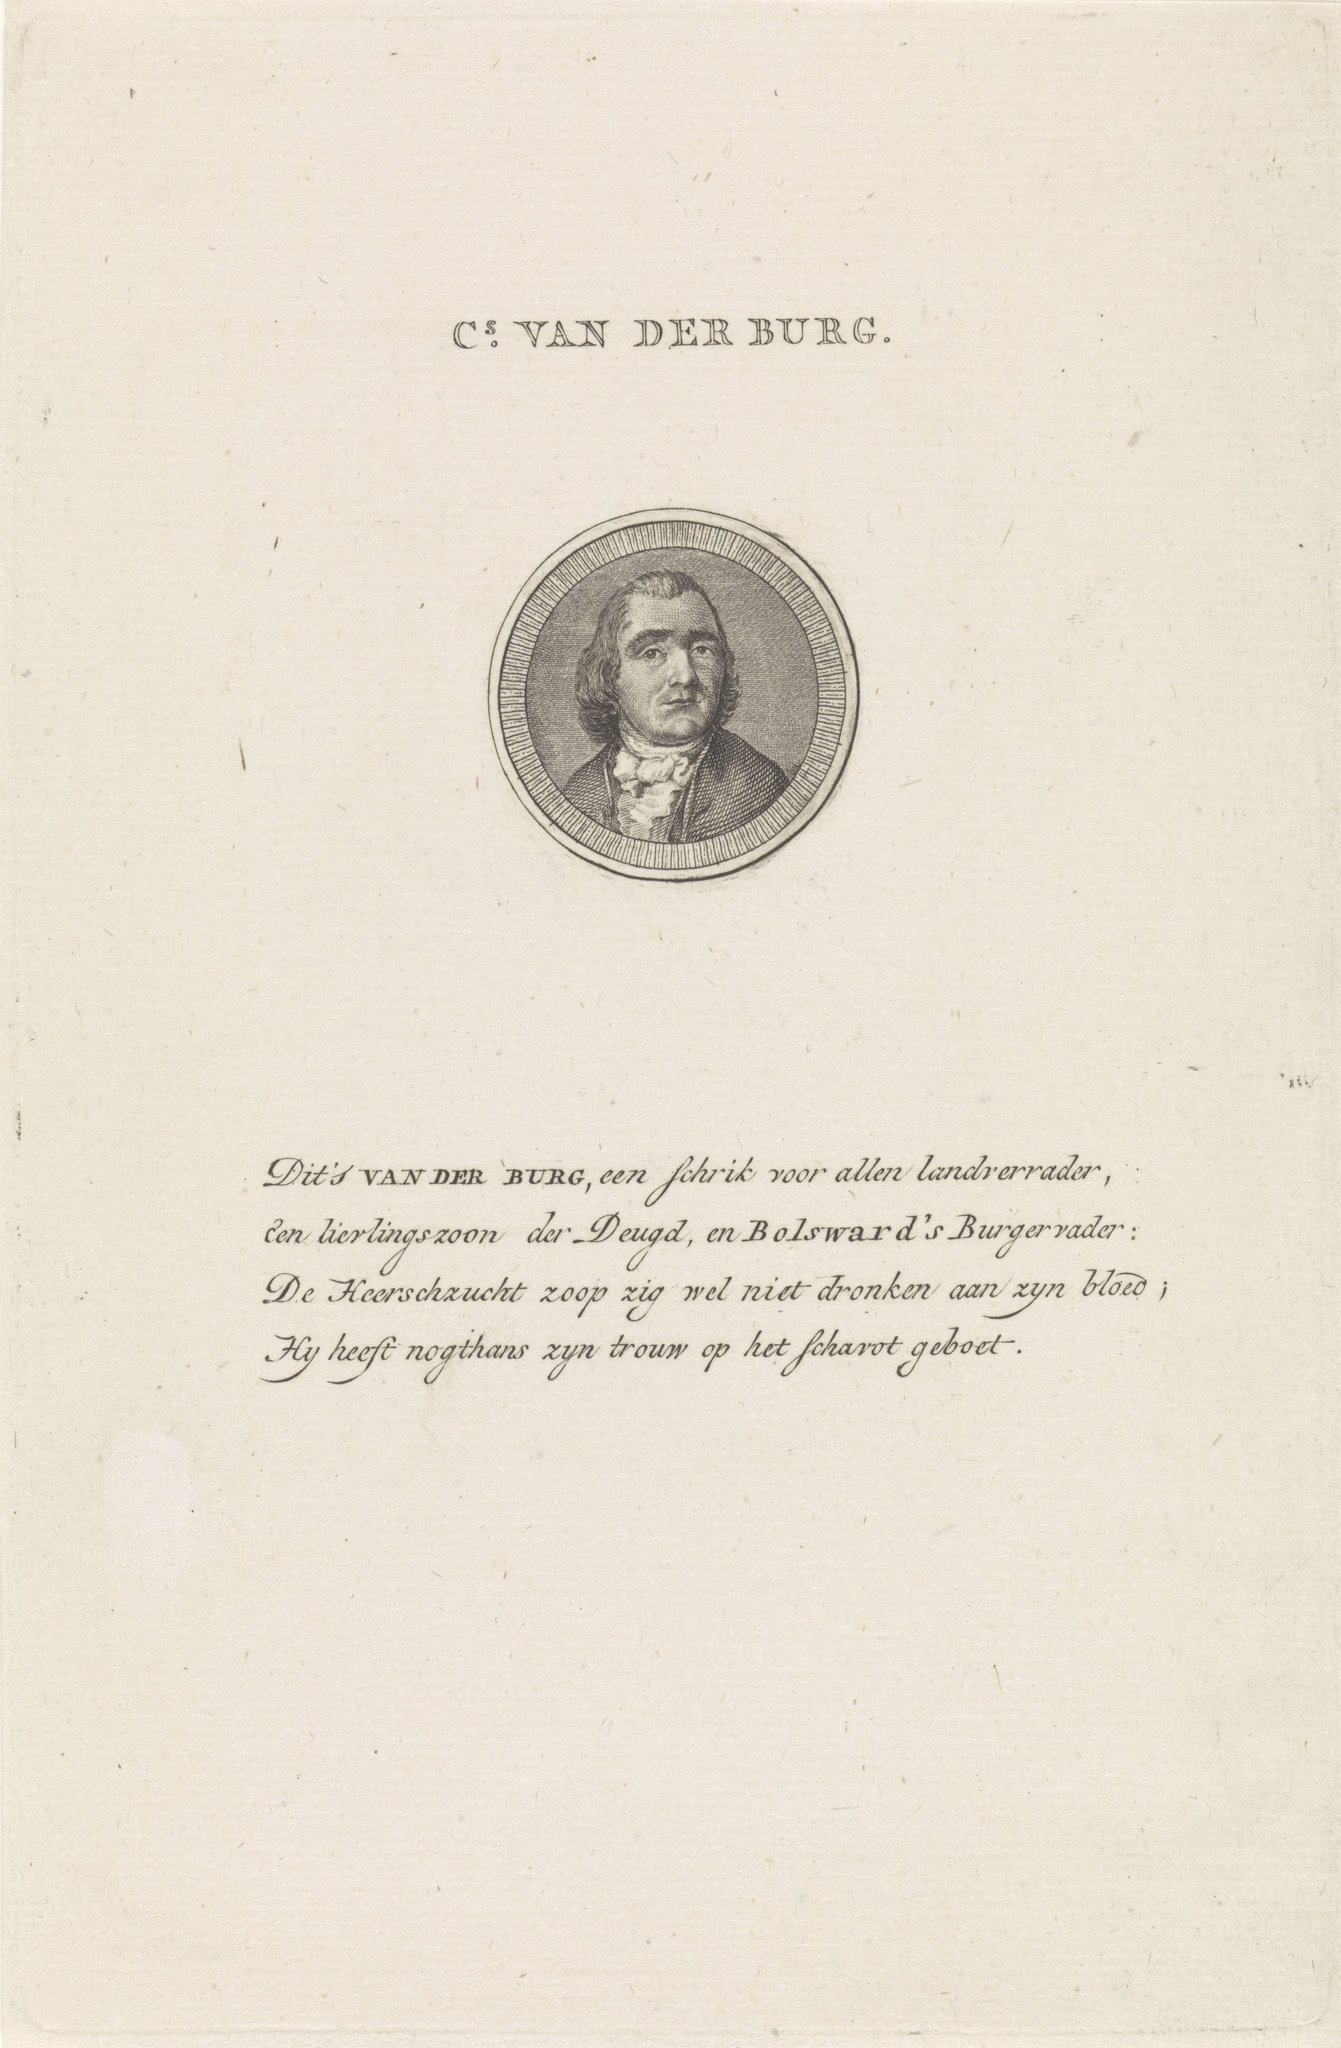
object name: print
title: Portret van Cornelis van der Burg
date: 1787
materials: paper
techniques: engraving, etching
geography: amsterdam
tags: mayor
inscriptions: collector's mark: Lugt 2228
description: Jacobus Wijsman heeft sommige platen van de serie patriottenportretten van Abraham Jacobsz. Hulk aangepast en hergebruikt in zijn eigen serie patriottenportretten. Prent maakt deel uit van een serie, die in drie afleveringen werd uitgegeven onder de titel: Verzameling van Afbeeldingen van Nederlandsche Mannen, beroemd geworden, wegens hunne Moed en Burgerliefde in de jongstledene Beroerten. 1794-1795. Zie Atlas van Stolk.